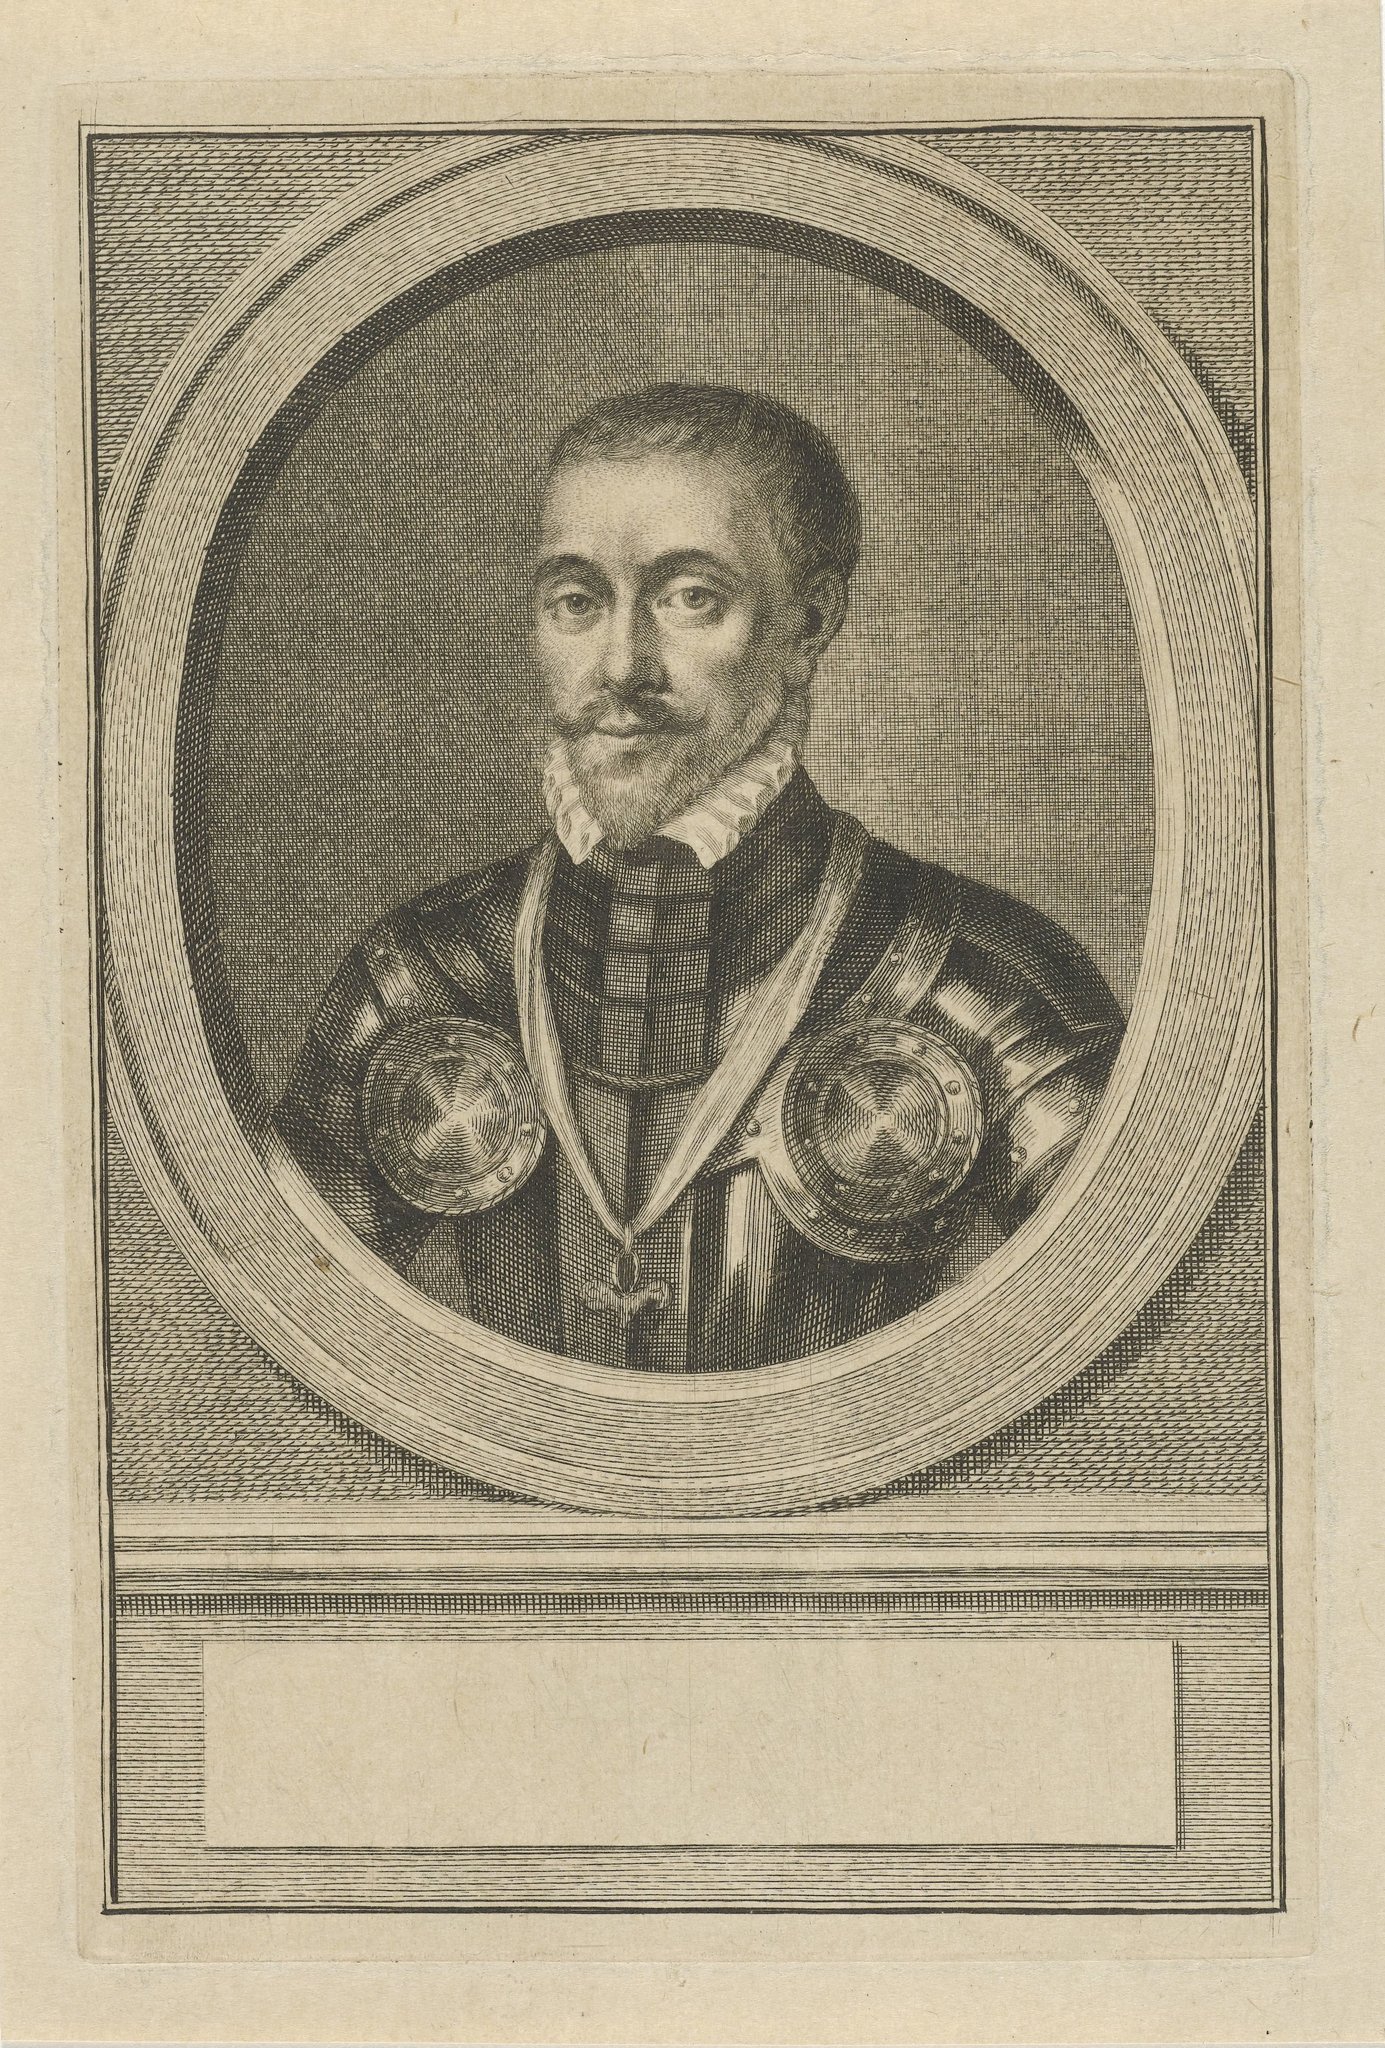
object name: print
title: Portret van Hendrik van Brederode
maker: jacob houbraken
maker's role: draughtsman, print maker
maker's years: 1698-1780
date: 1747-1759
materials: paper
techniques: engraving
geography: amsterdam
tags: hendrik van brederode (heer van vianen)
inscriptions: collector's mark: Lugt 2228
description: Proefdruk van de prent oorspronkelijk bedoeld voor: Jan Wagenaar, Vaderlandsche historie, vervattende de geschiedenissen der nu Vereenigde Nederlanden, inzonderheid die van Holland (...), 21 delen. Amsterdam, Isaak Tirion, 1749-59.